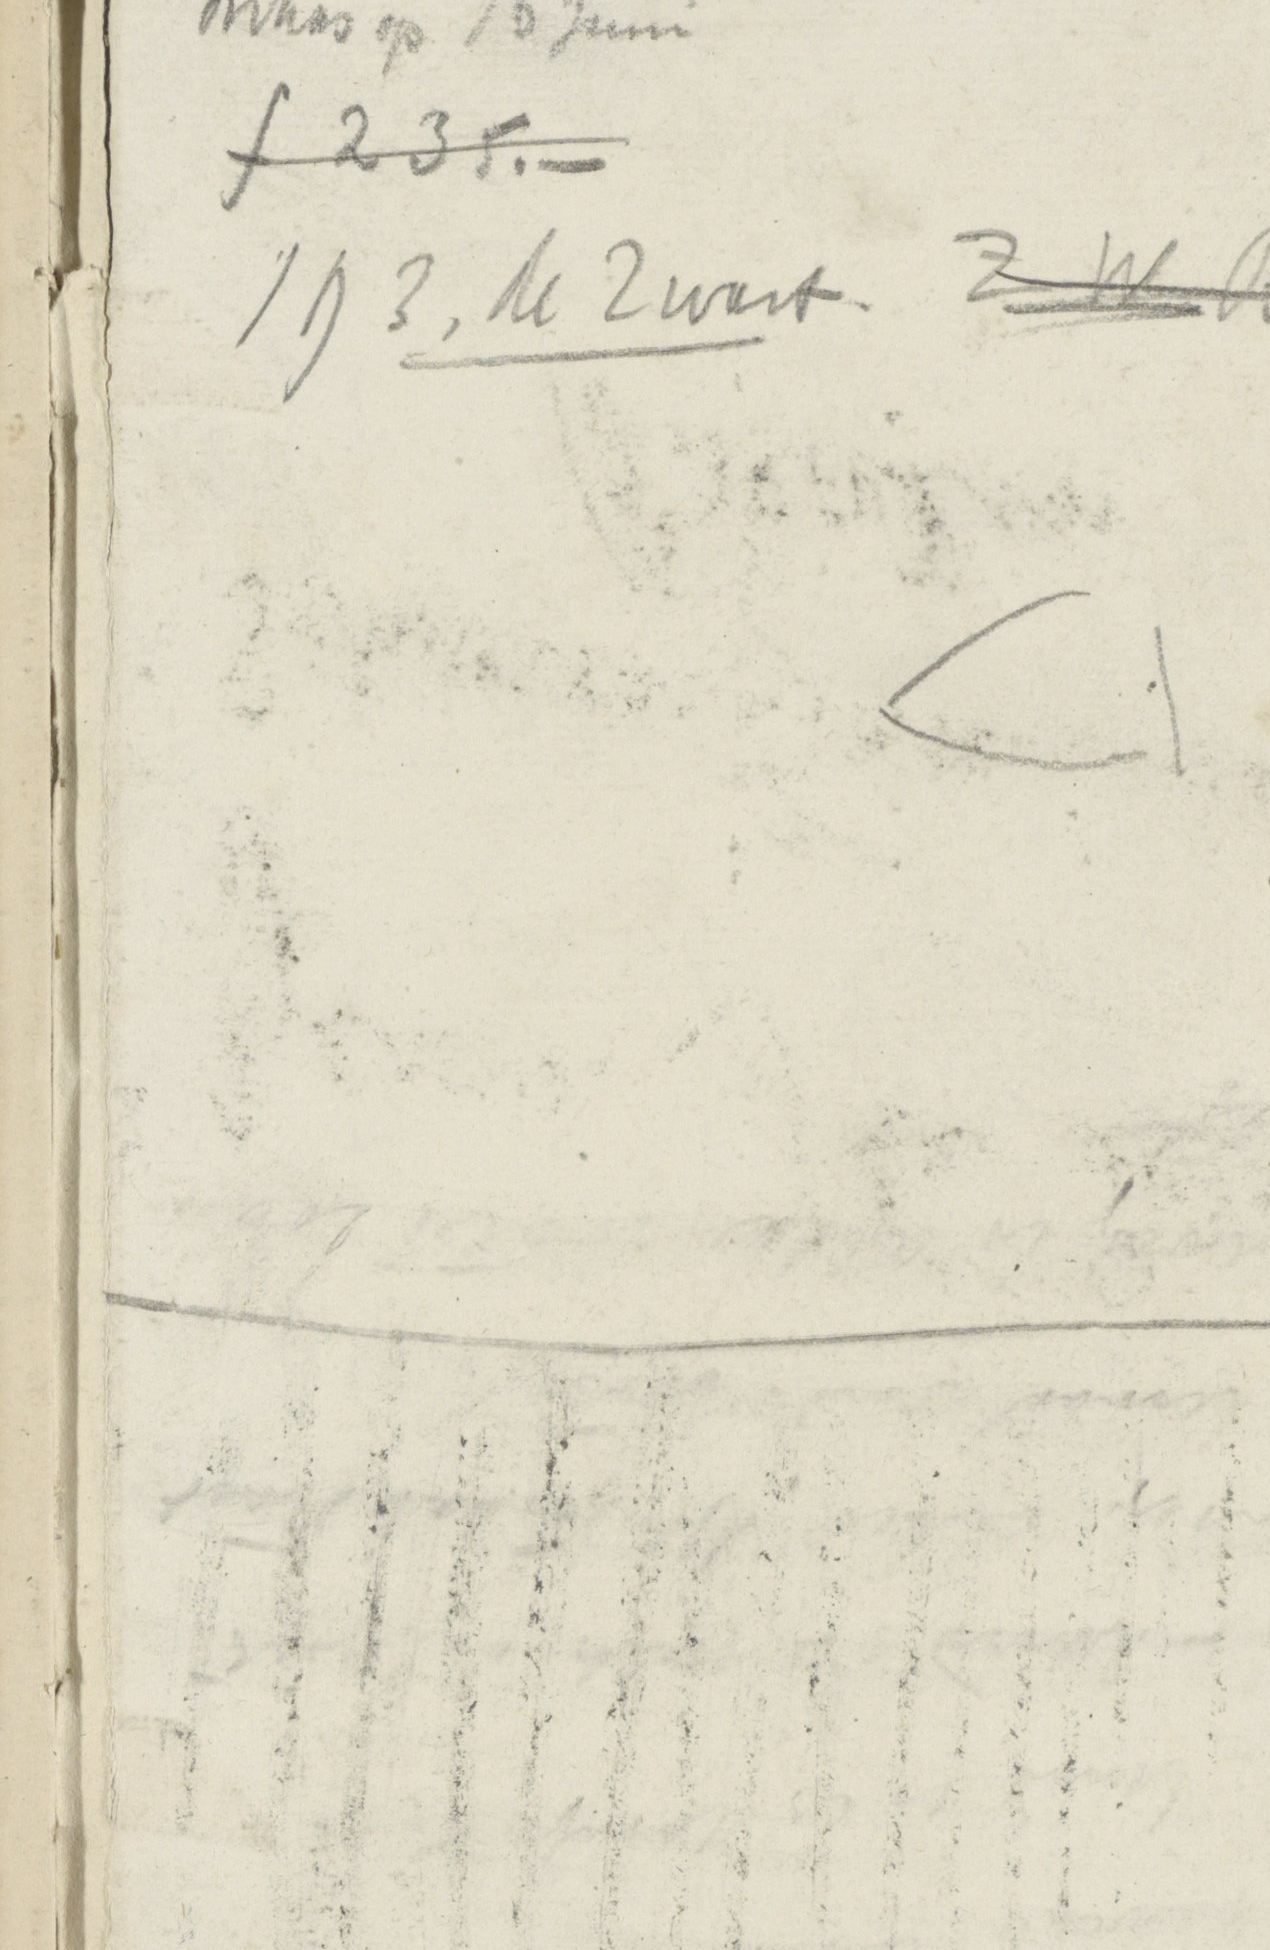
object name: sketchbook leaf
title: Studie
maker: george hendrik breitner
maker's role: draughtsman, painter, print maker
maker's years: 1857-1923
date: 1886-1923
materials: paper, pencil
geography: amsterdam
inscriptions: annotation: ‘[...] op 16 juni/ 193, de Zwart’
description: Pagina 30, achterste schutblad, uit een schetsboek met 14 bladen.